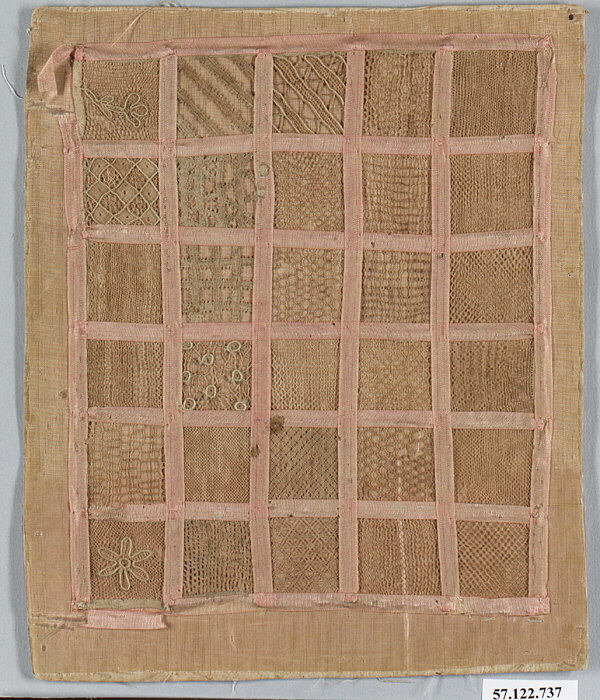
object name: sampler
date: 1801-1900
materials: ribbon, silk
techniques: embroidery, lace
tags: flowers